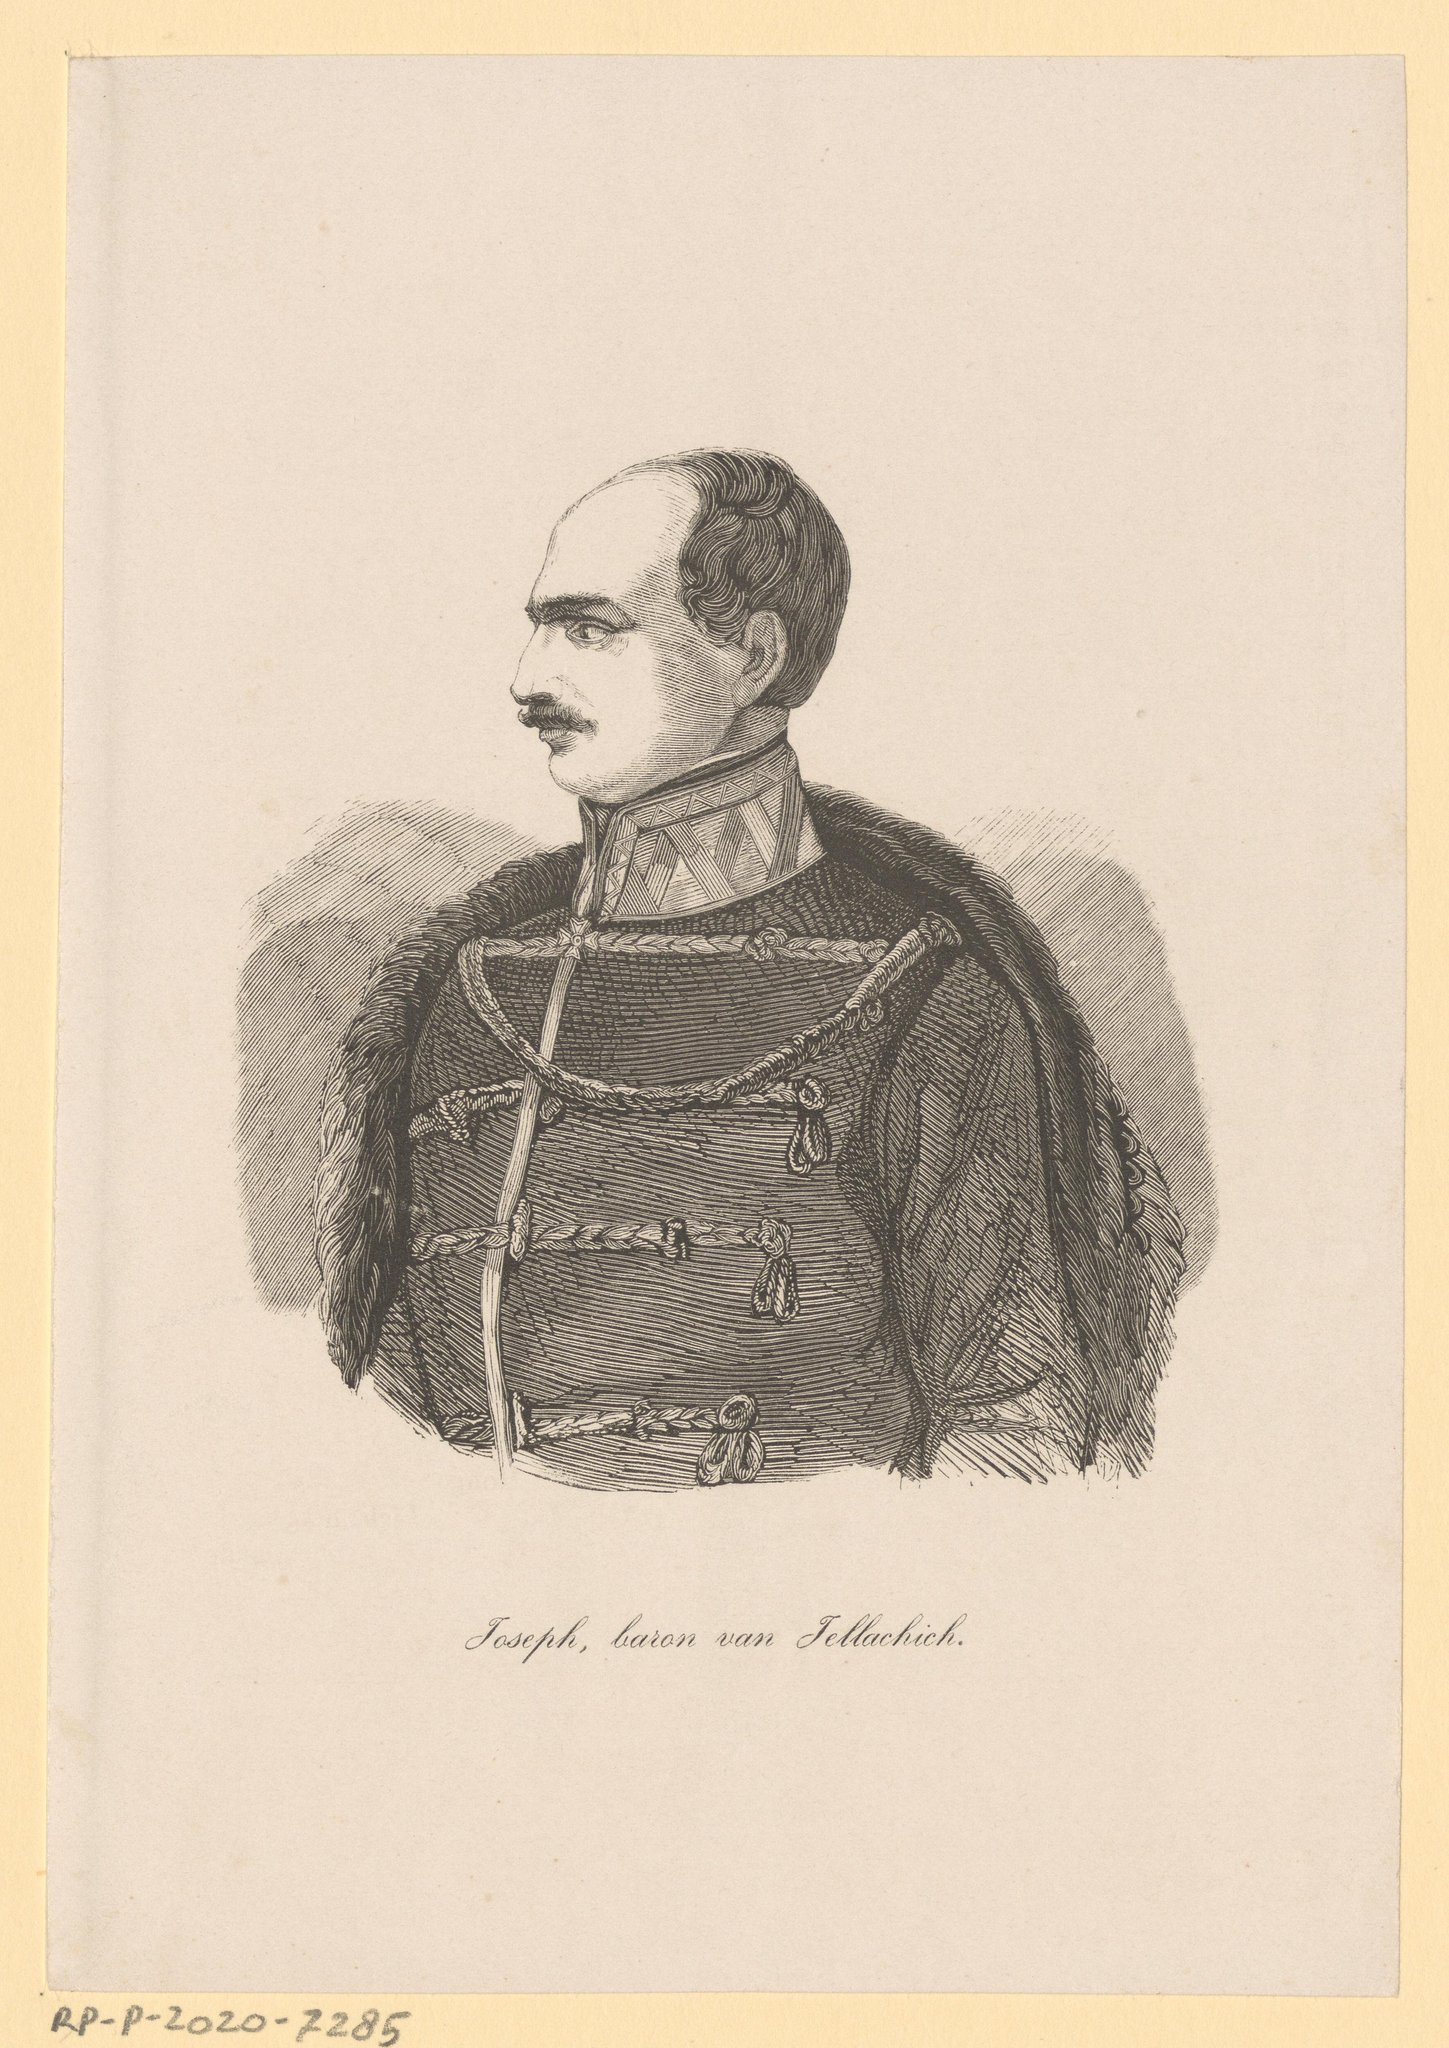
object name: print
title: Portret van graaf Josip Jelačić od Bužima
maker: Anonymous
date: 1819-1899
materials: paper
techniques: engraving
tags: commander-in-chief, general, marshal, historical persons